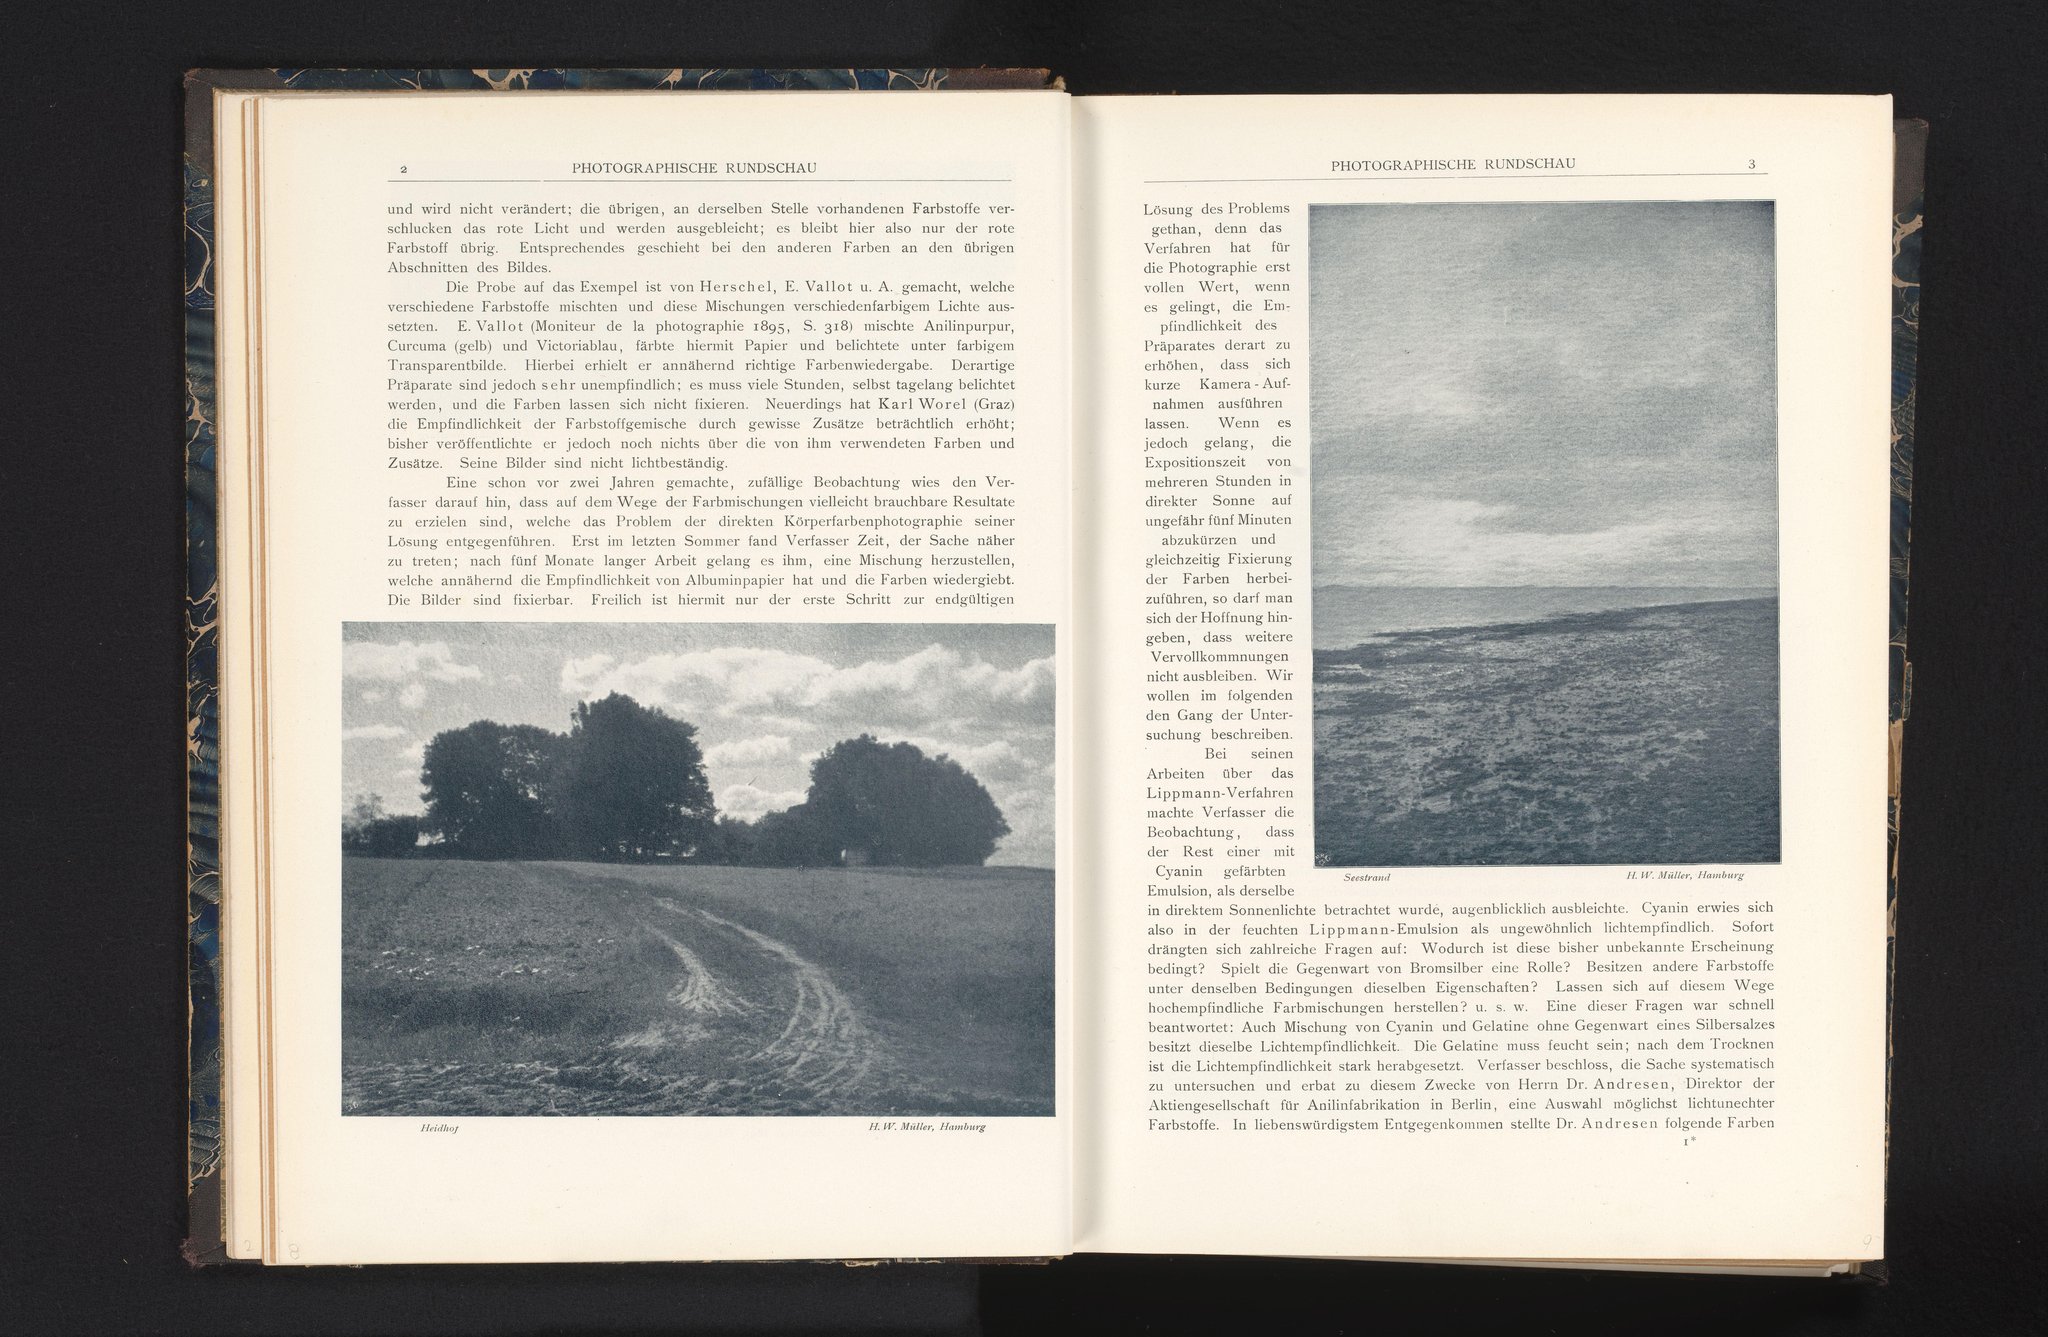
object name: photomechanical print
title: Heidhof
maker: h.w. müller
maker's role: fotograaf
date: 1897-1902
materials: paper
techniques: autotype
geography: berlin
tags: trees, landscapes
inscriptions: monogram: ‘MR&C’